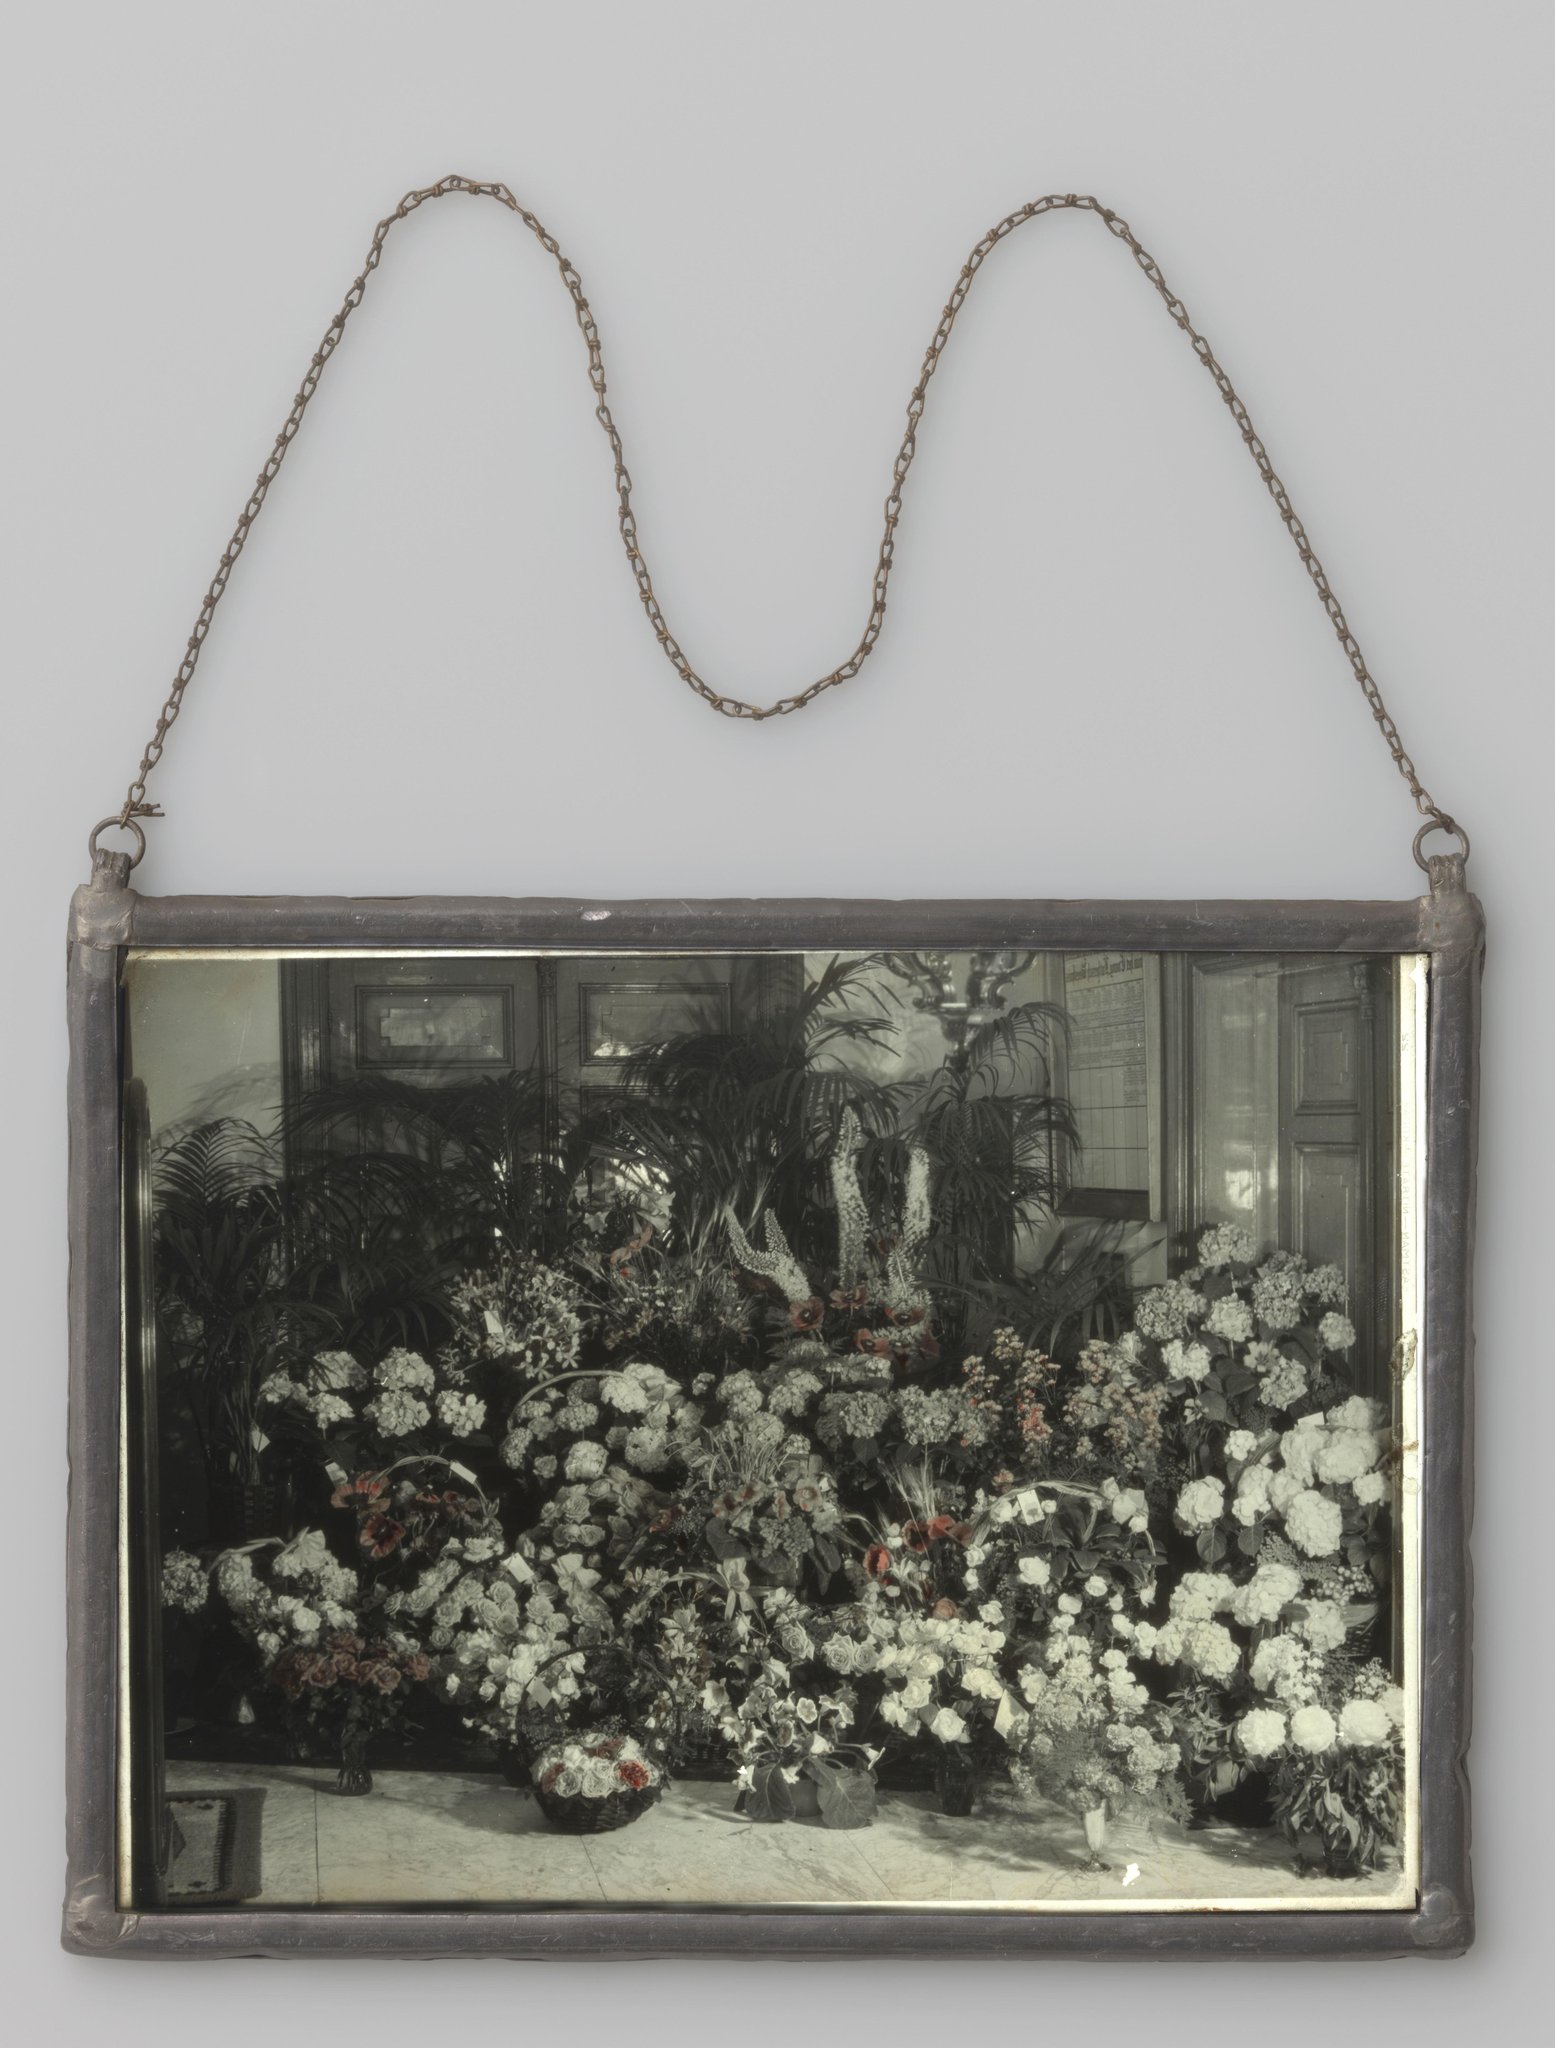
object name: frame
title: Bloemen in een kamer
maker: Anonymous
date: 1900-1920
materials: film, glass, lead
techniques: hand coloring, slide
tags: flowers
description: Mogelijk het interieur van een bloemenwinkel.